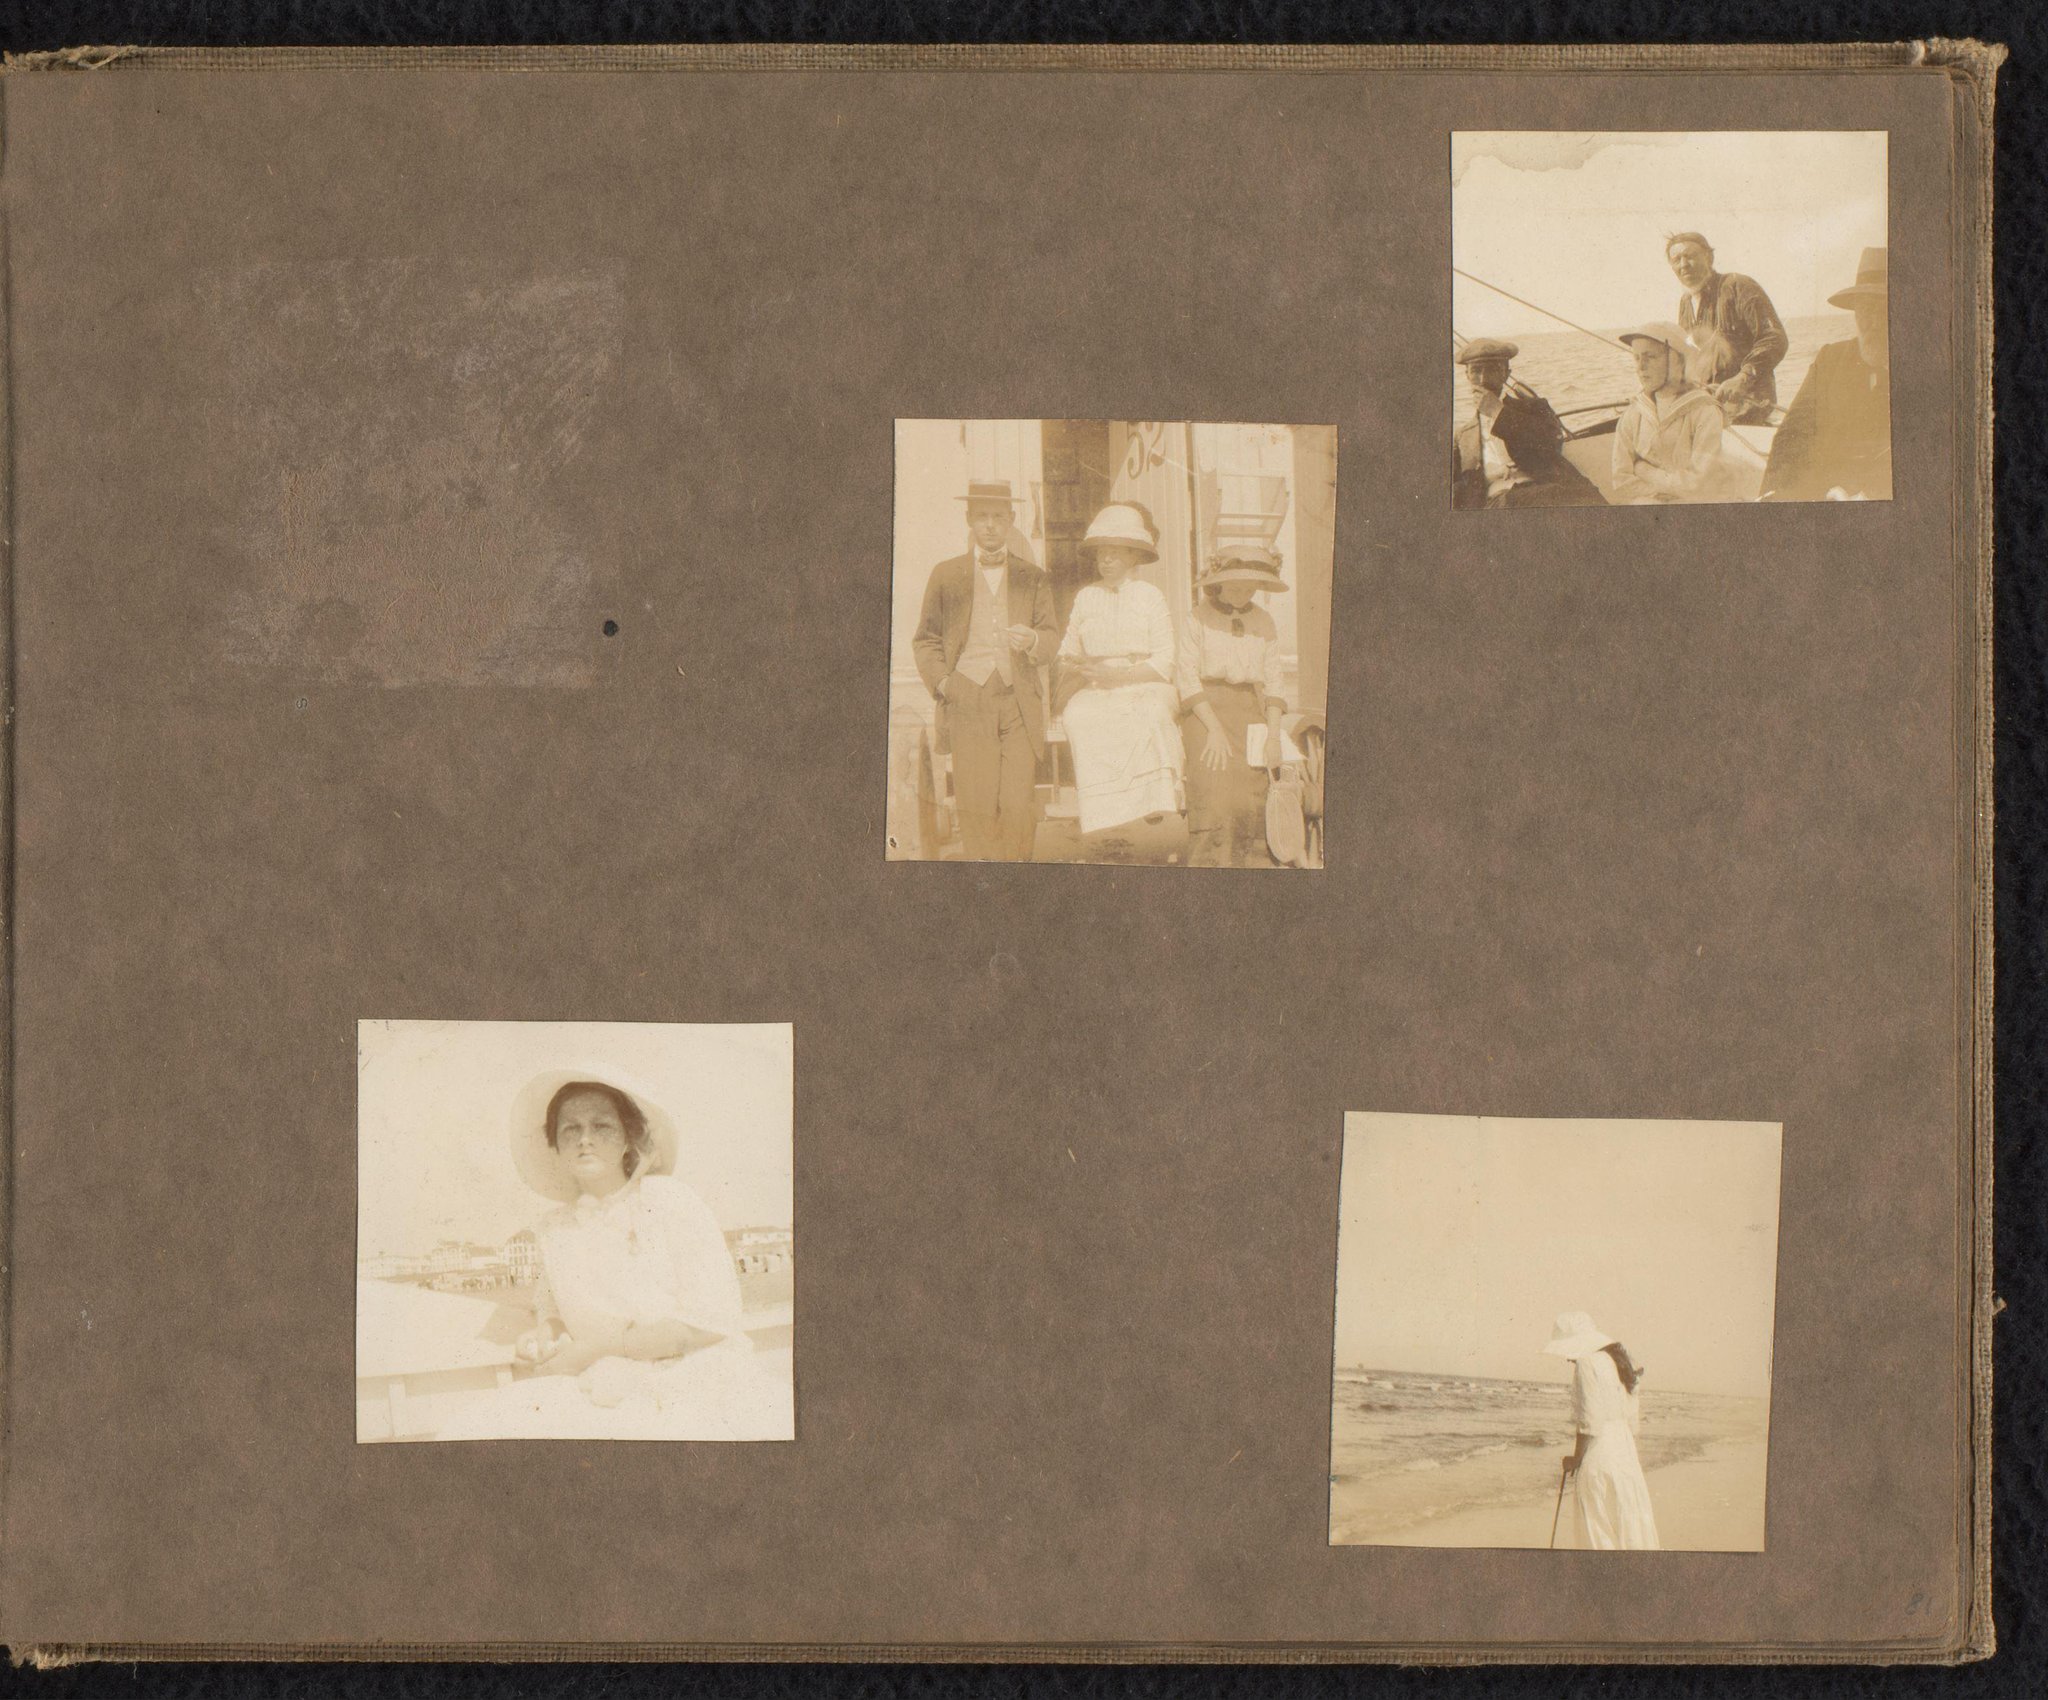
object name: album leaf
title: Vier foto's van een vakantie in Noordwijk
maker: carolina frederika onnen (lien/loen)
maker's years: 1896-1983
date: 1908-1911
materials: paper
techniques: gelatin silver print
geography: noordwijk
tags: beach (as place of recreation)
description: Deze foto's maken deel uit van een album.